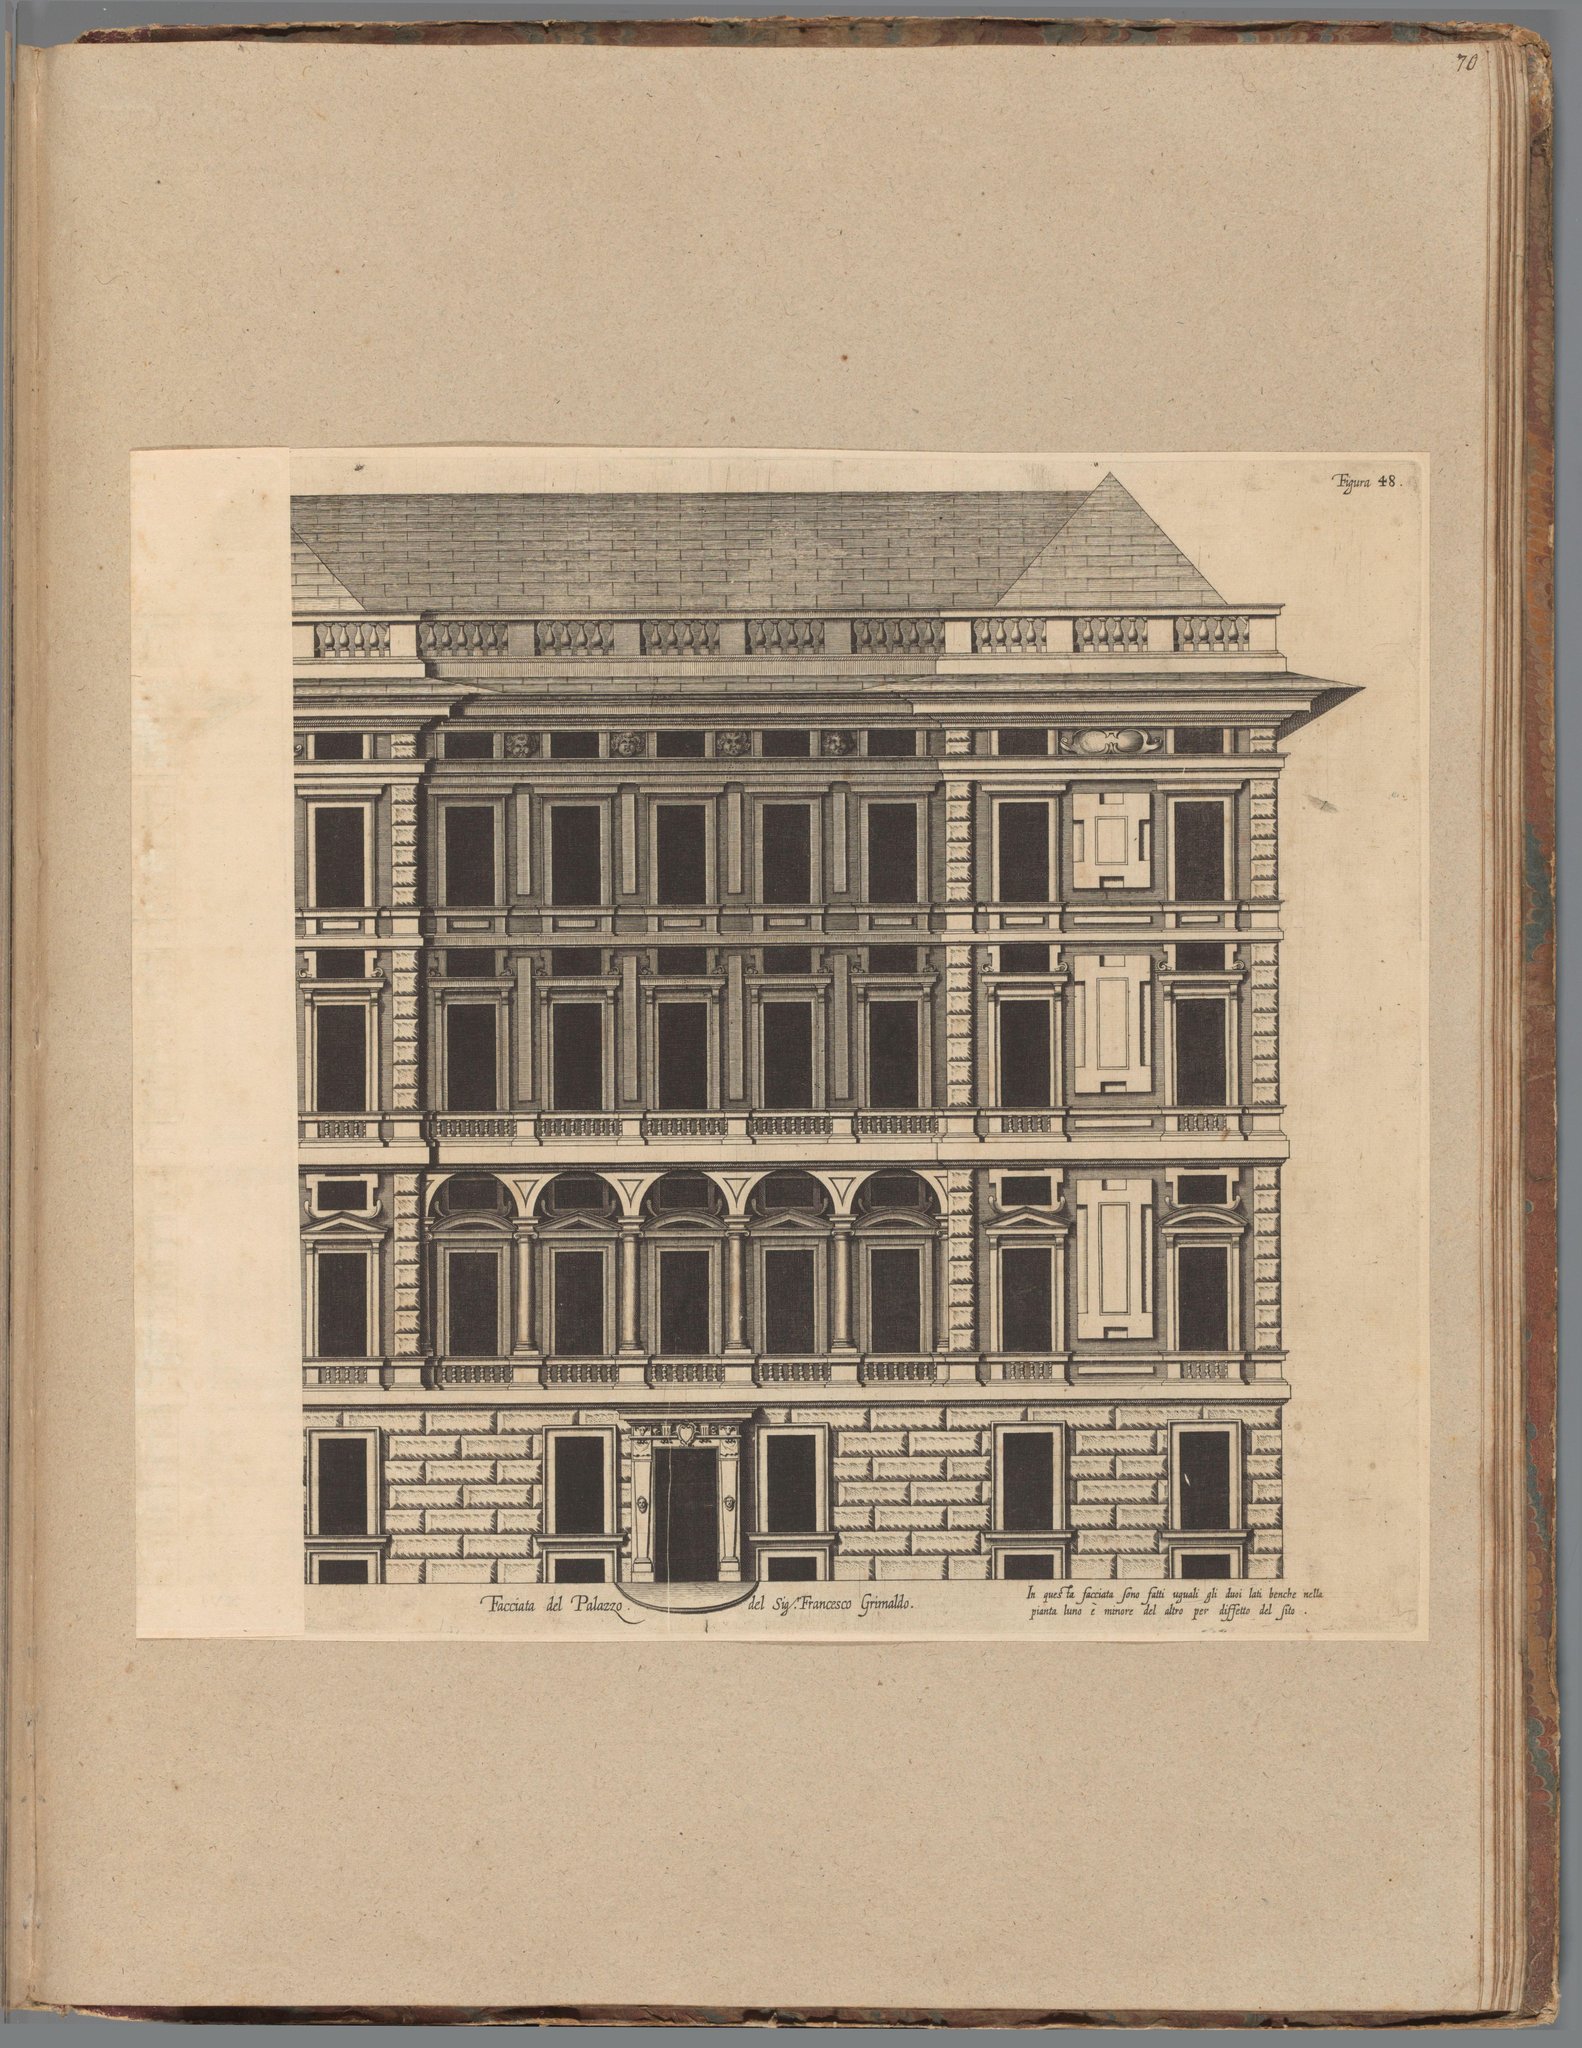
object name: album leaf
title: Opstand van de façade van het Palazzo Spinola di Pellicceria te Genua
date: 1622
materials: paper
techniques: engraving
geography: antwerp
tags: hôtel, i.e. small palace in city, façade (of house or building), exterior ~ architectural design or model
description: Rechtsonder een tweeregelige toelichting in het Italiaans. Deze prent maakt deel uit van een album.